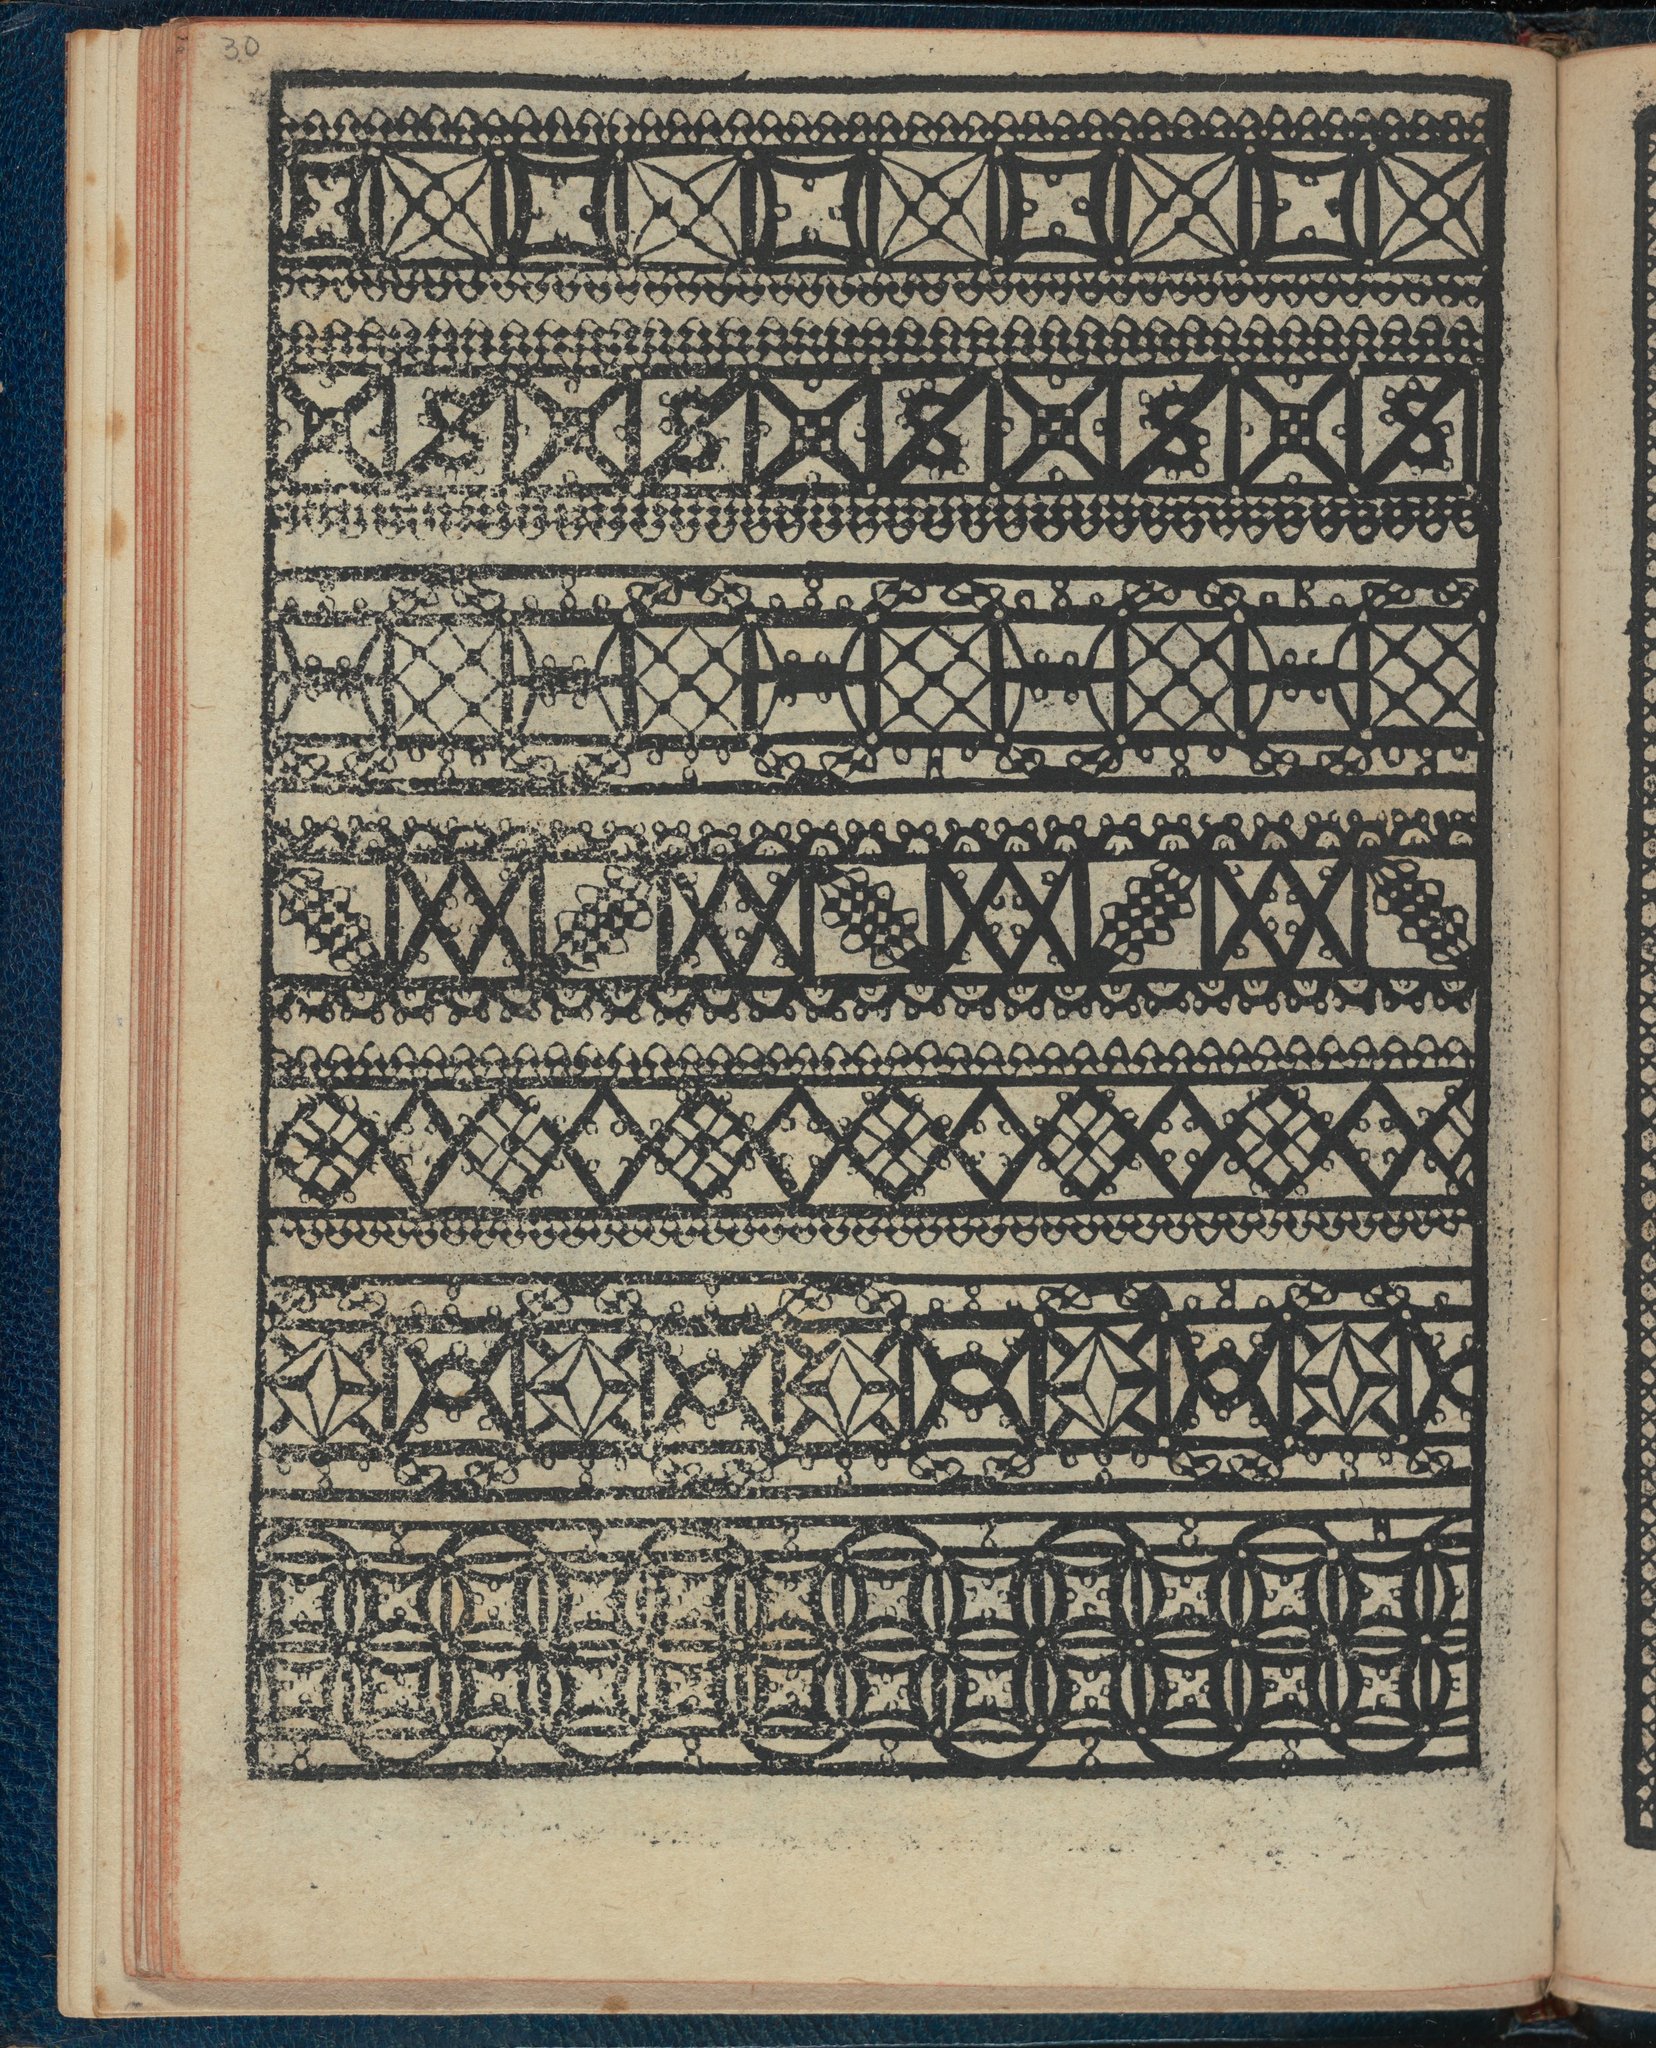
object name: book print ornament architecture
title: Le Pompe: Opera Nova, page 15 (verso)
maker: giovanni battista & marchio sessa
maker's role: publisher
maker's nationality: italian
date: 1557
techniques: woodcut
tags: ornament